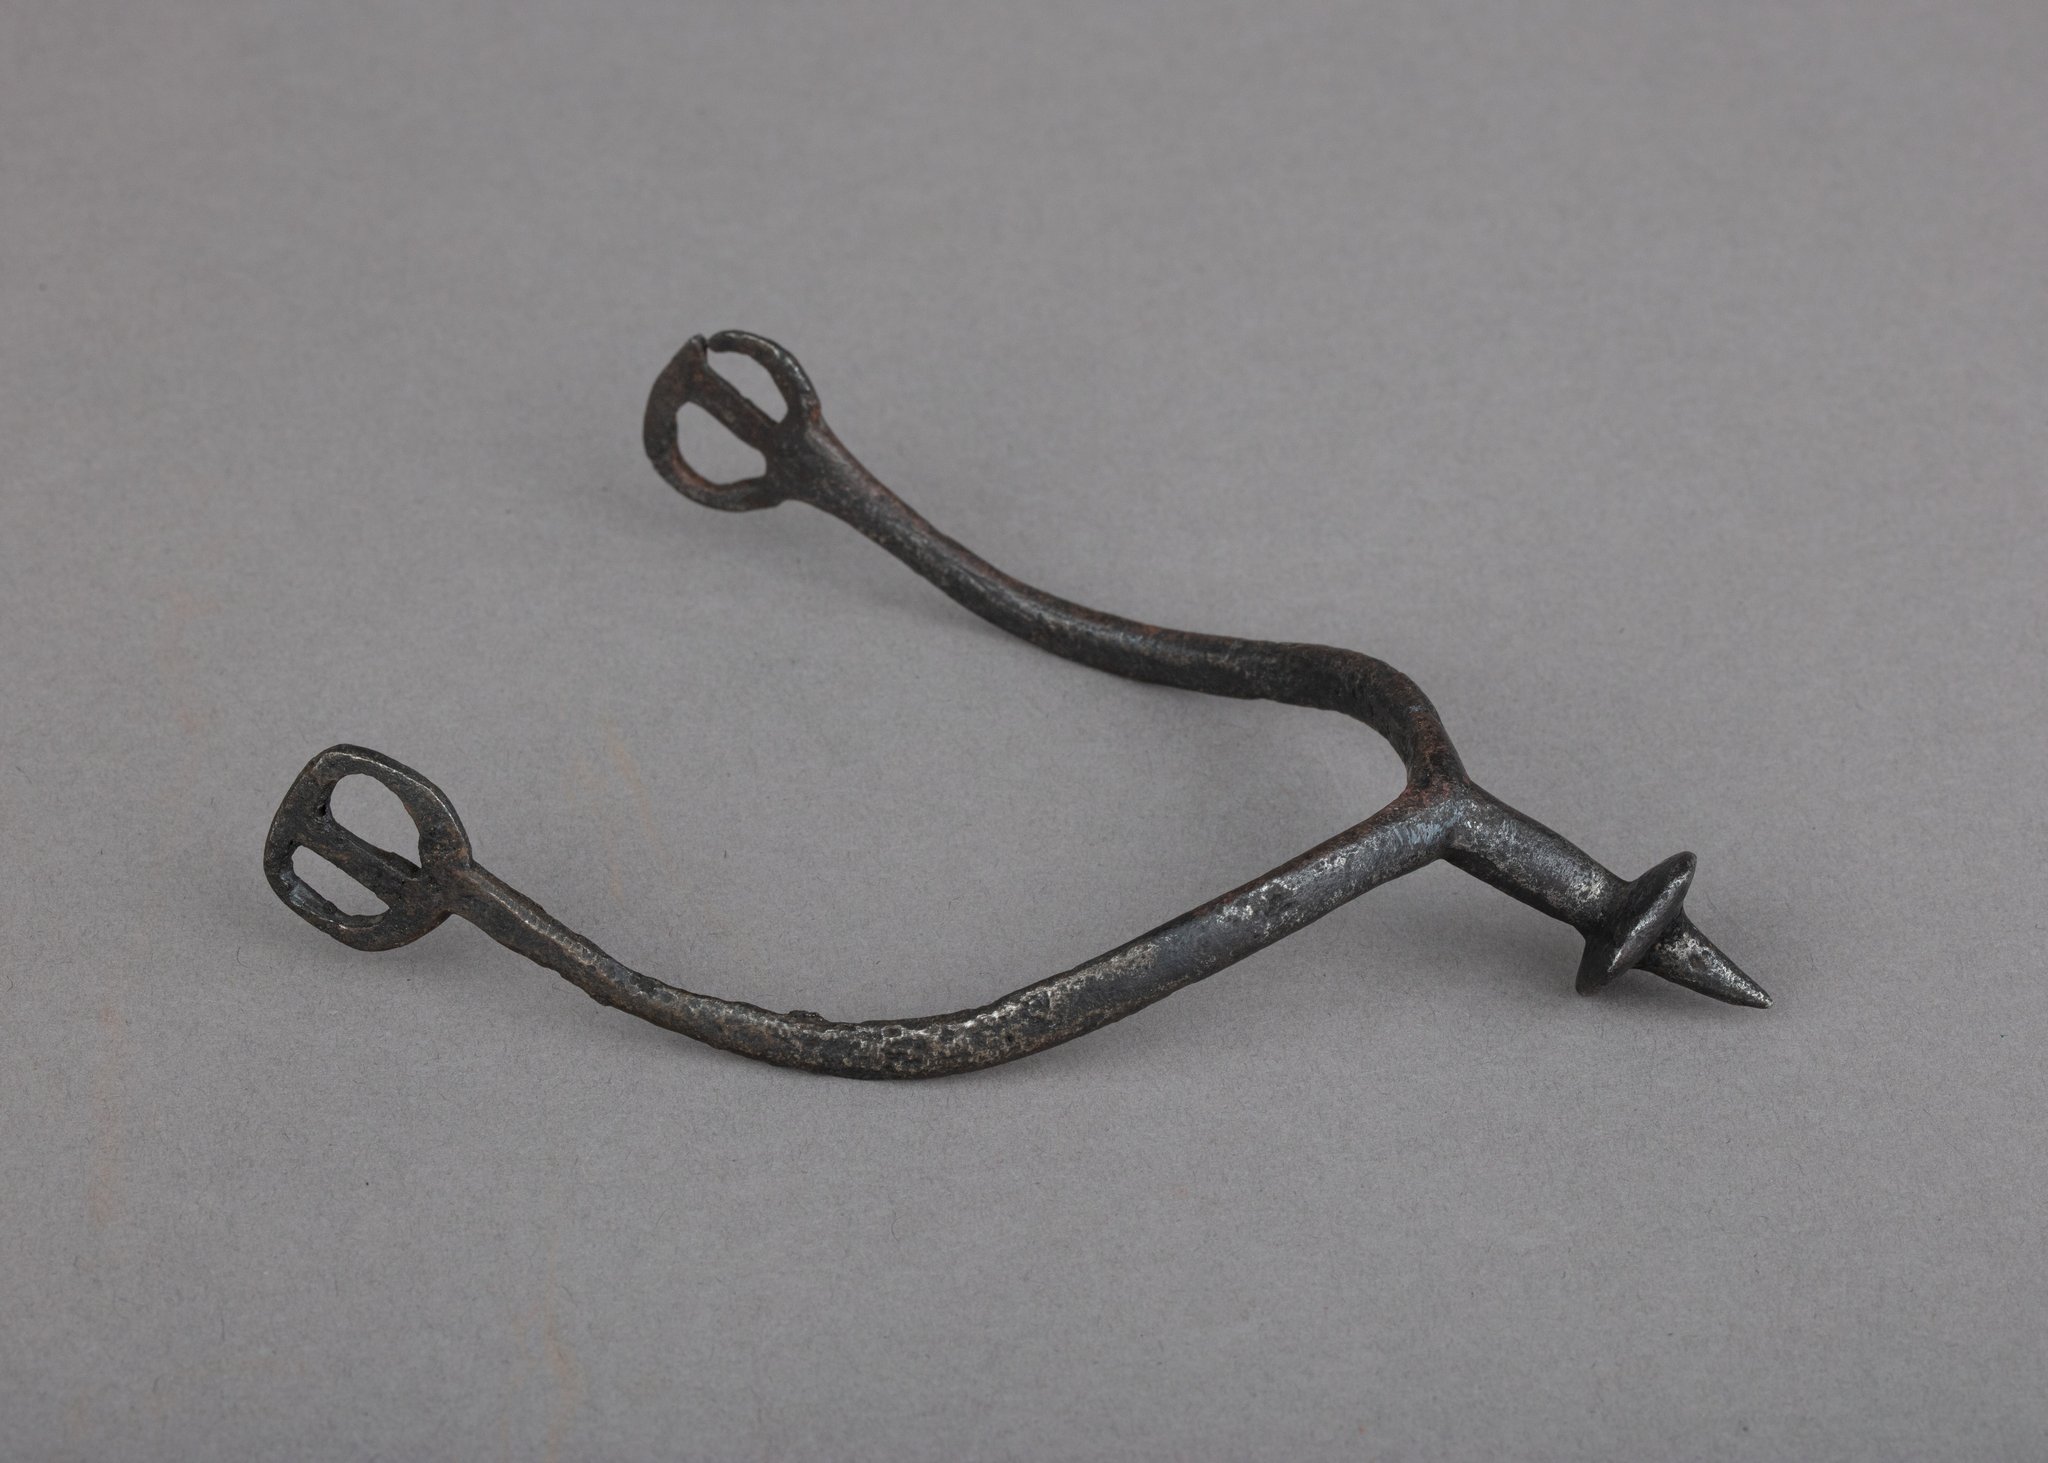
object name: spur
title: Prick Spur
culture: german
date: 1201-1300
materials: metal alloy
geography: germany